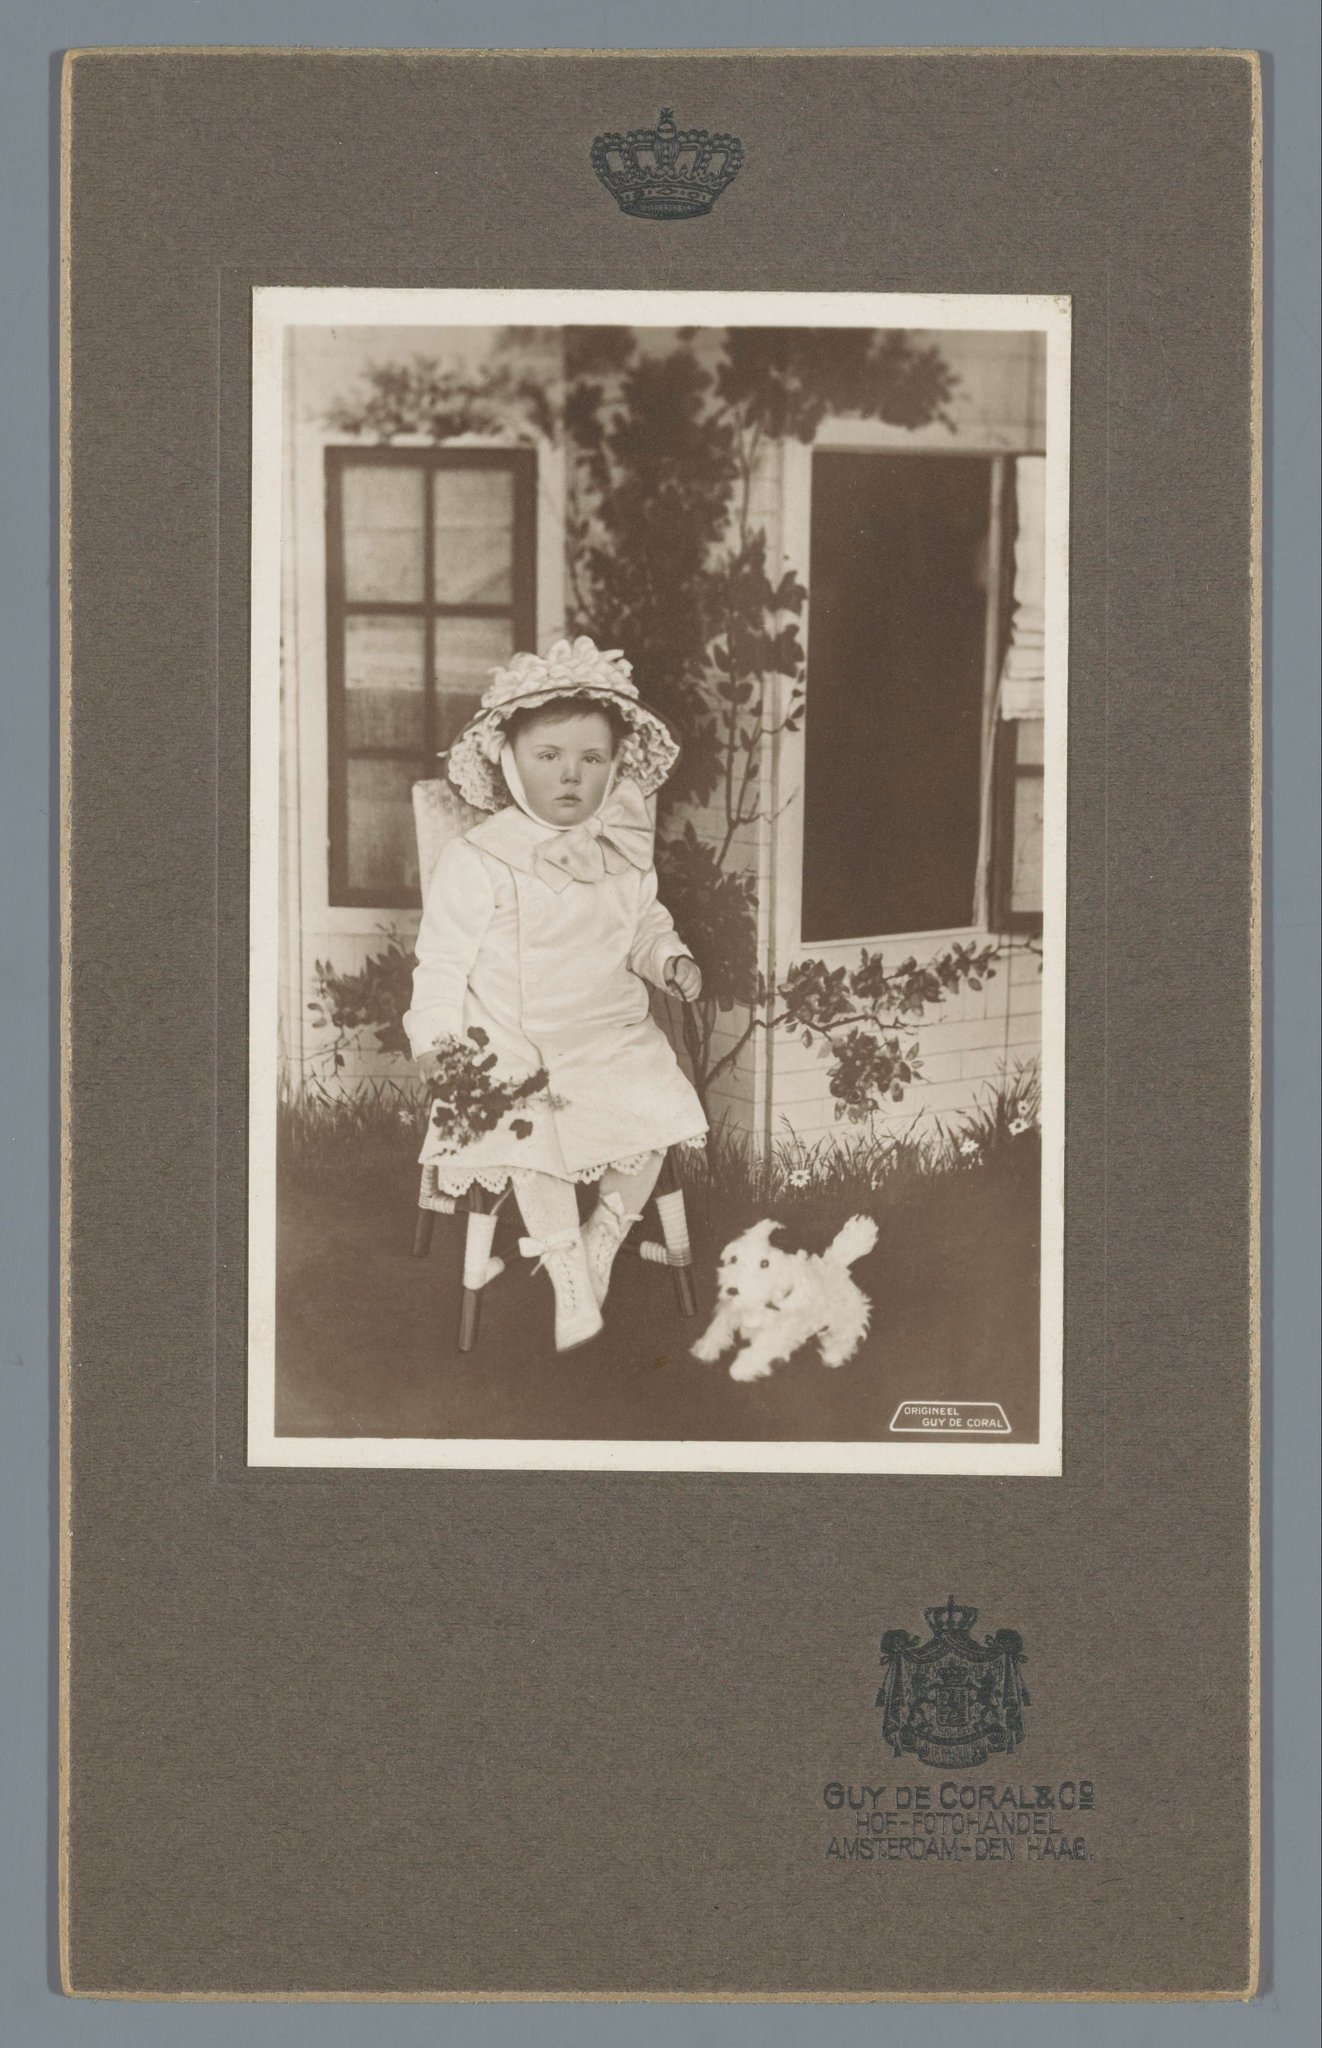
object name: cabinet photograph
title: Portret van prinses Juliana met speelgoedhond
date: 1912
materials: cardboard, photographic support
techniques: matte daylight collodion silver print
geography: netherlands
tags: juliana of the netherlands, crown princess, historical persons, dog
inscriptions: inscription: ‘1912’, number: ‘40’, name: ‘GUY DE CORAL & CO./ HOF-FOTOHANDEL/ AMSTERDAM-DEN HAAG’